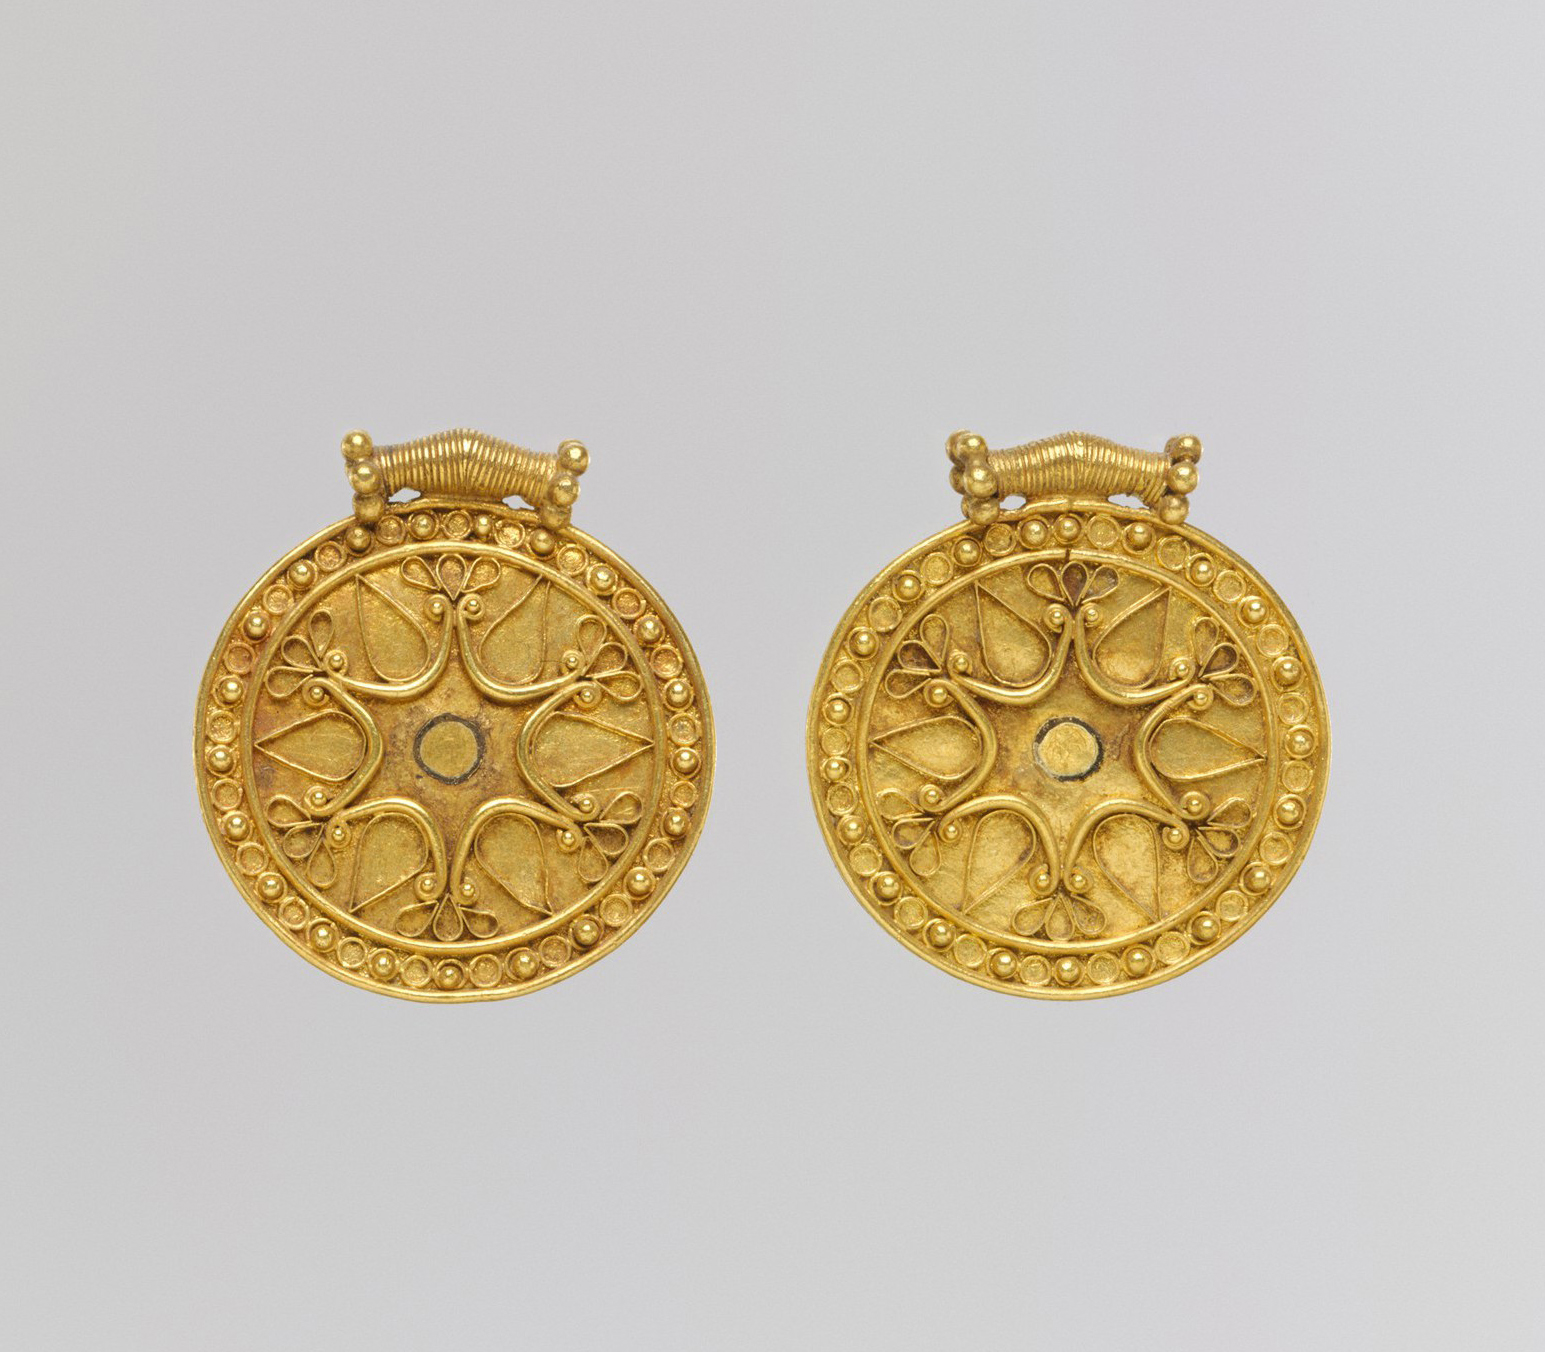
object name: pendant disc with lotus flower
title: Gold pendant disk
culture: cypriot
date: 700-501 BCE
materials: gold